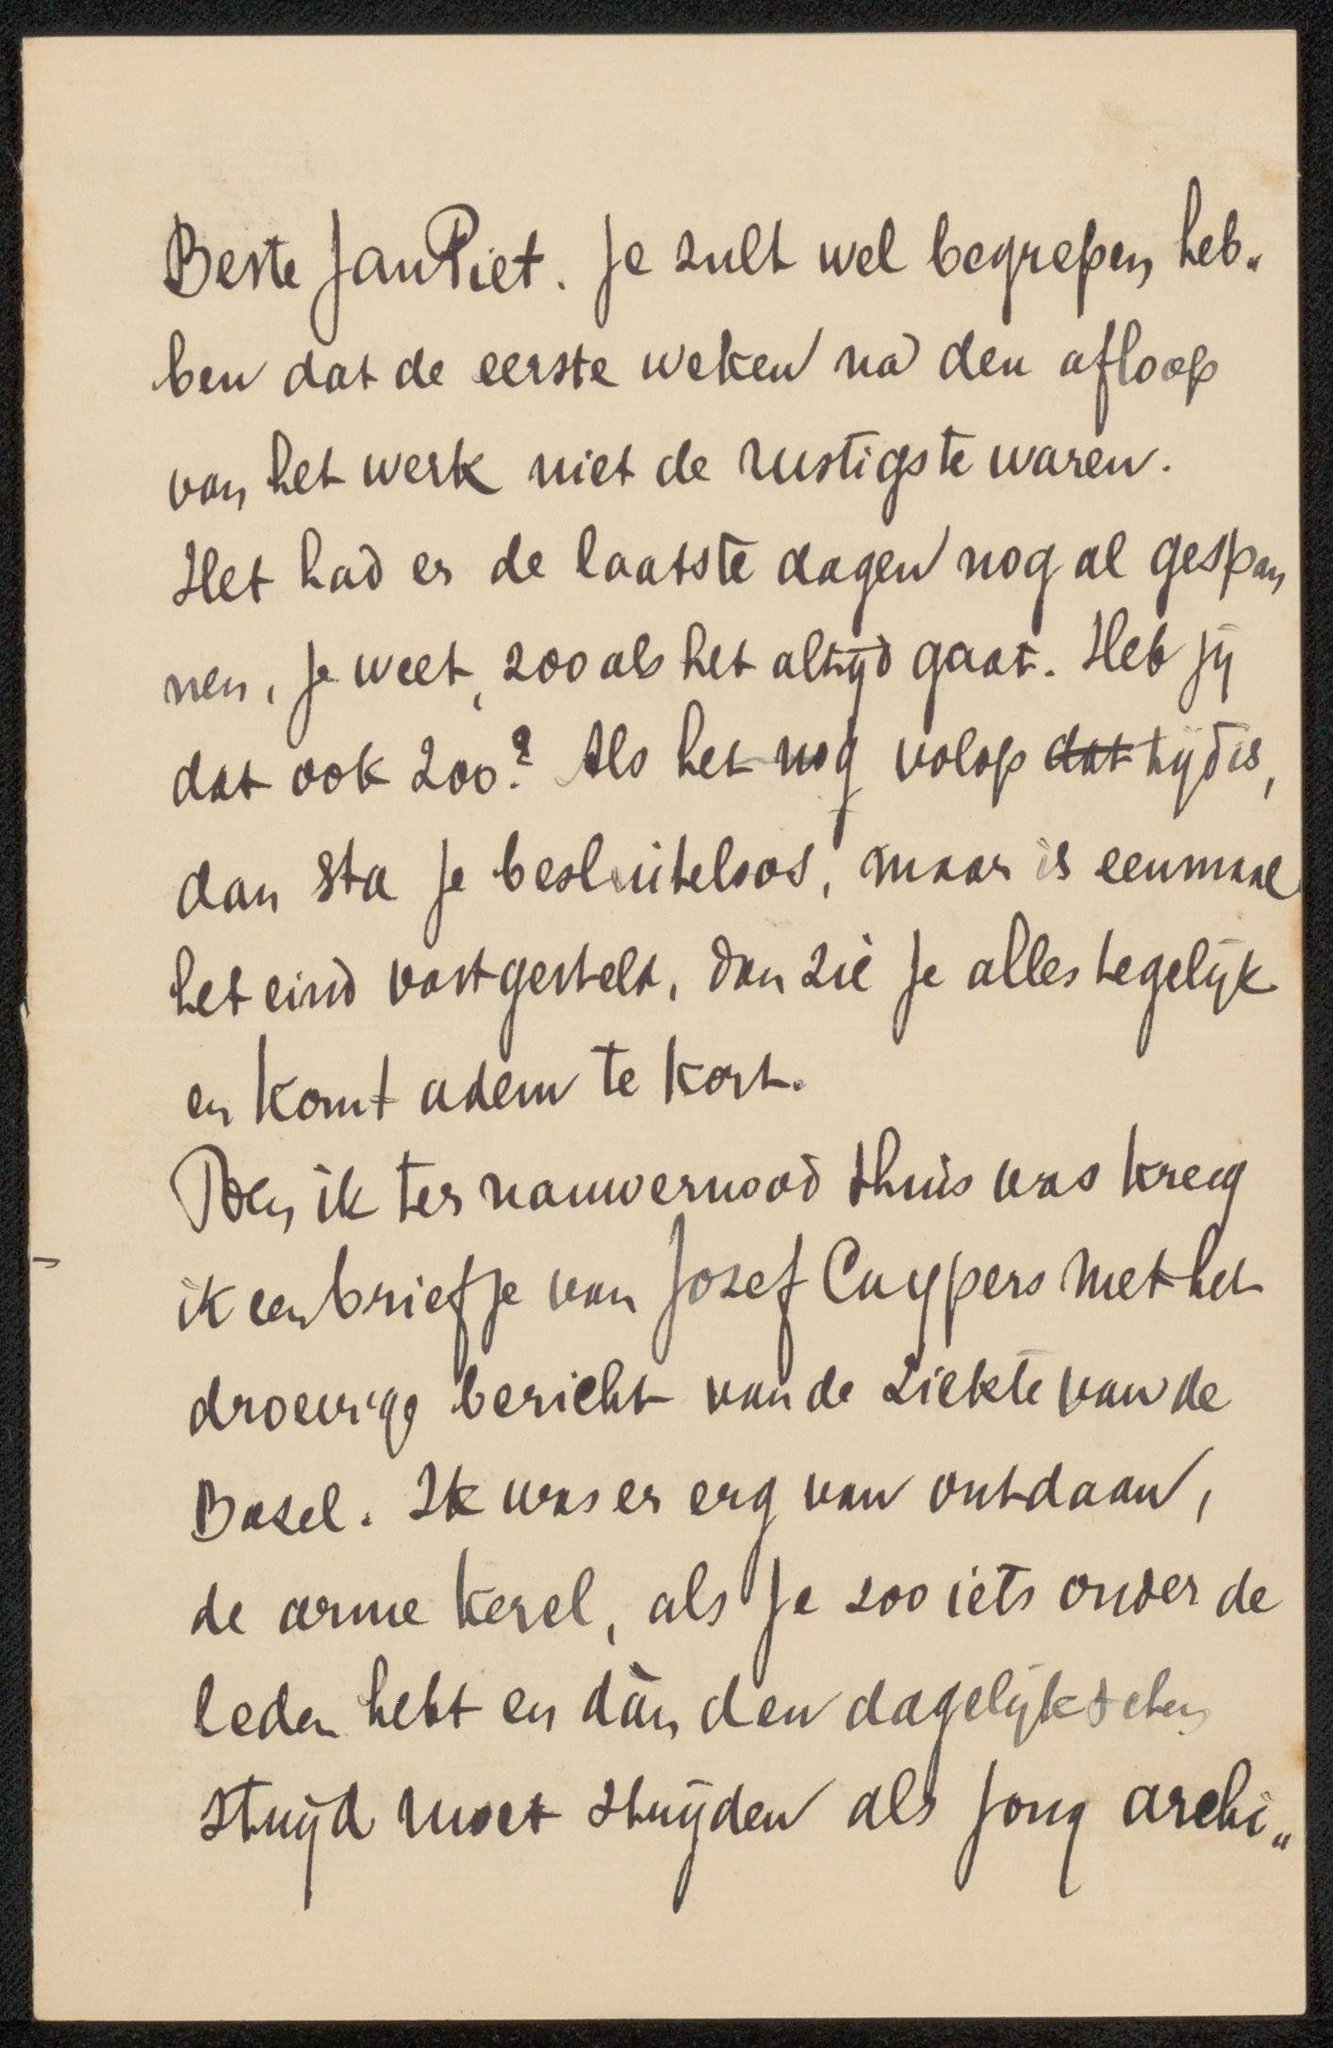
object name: letter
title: Brief aan Jan Veth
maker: antoon derkinderen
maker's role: draughtsman, painter, print maker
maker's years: 1859-1925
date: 1900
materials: ink, paper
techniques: pen, writing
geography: laren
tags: dordrecht, painter, designer, jan veth, den helder, print maker, draughtsman, karel petrus cornelis de bazel, the hague, hendrik petrus berlage, sculptor, joseph theodorus johannes cuypers, drawing, exhibition ~ art, diseases, printed matter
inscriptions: collector's mark: ‘RPK’